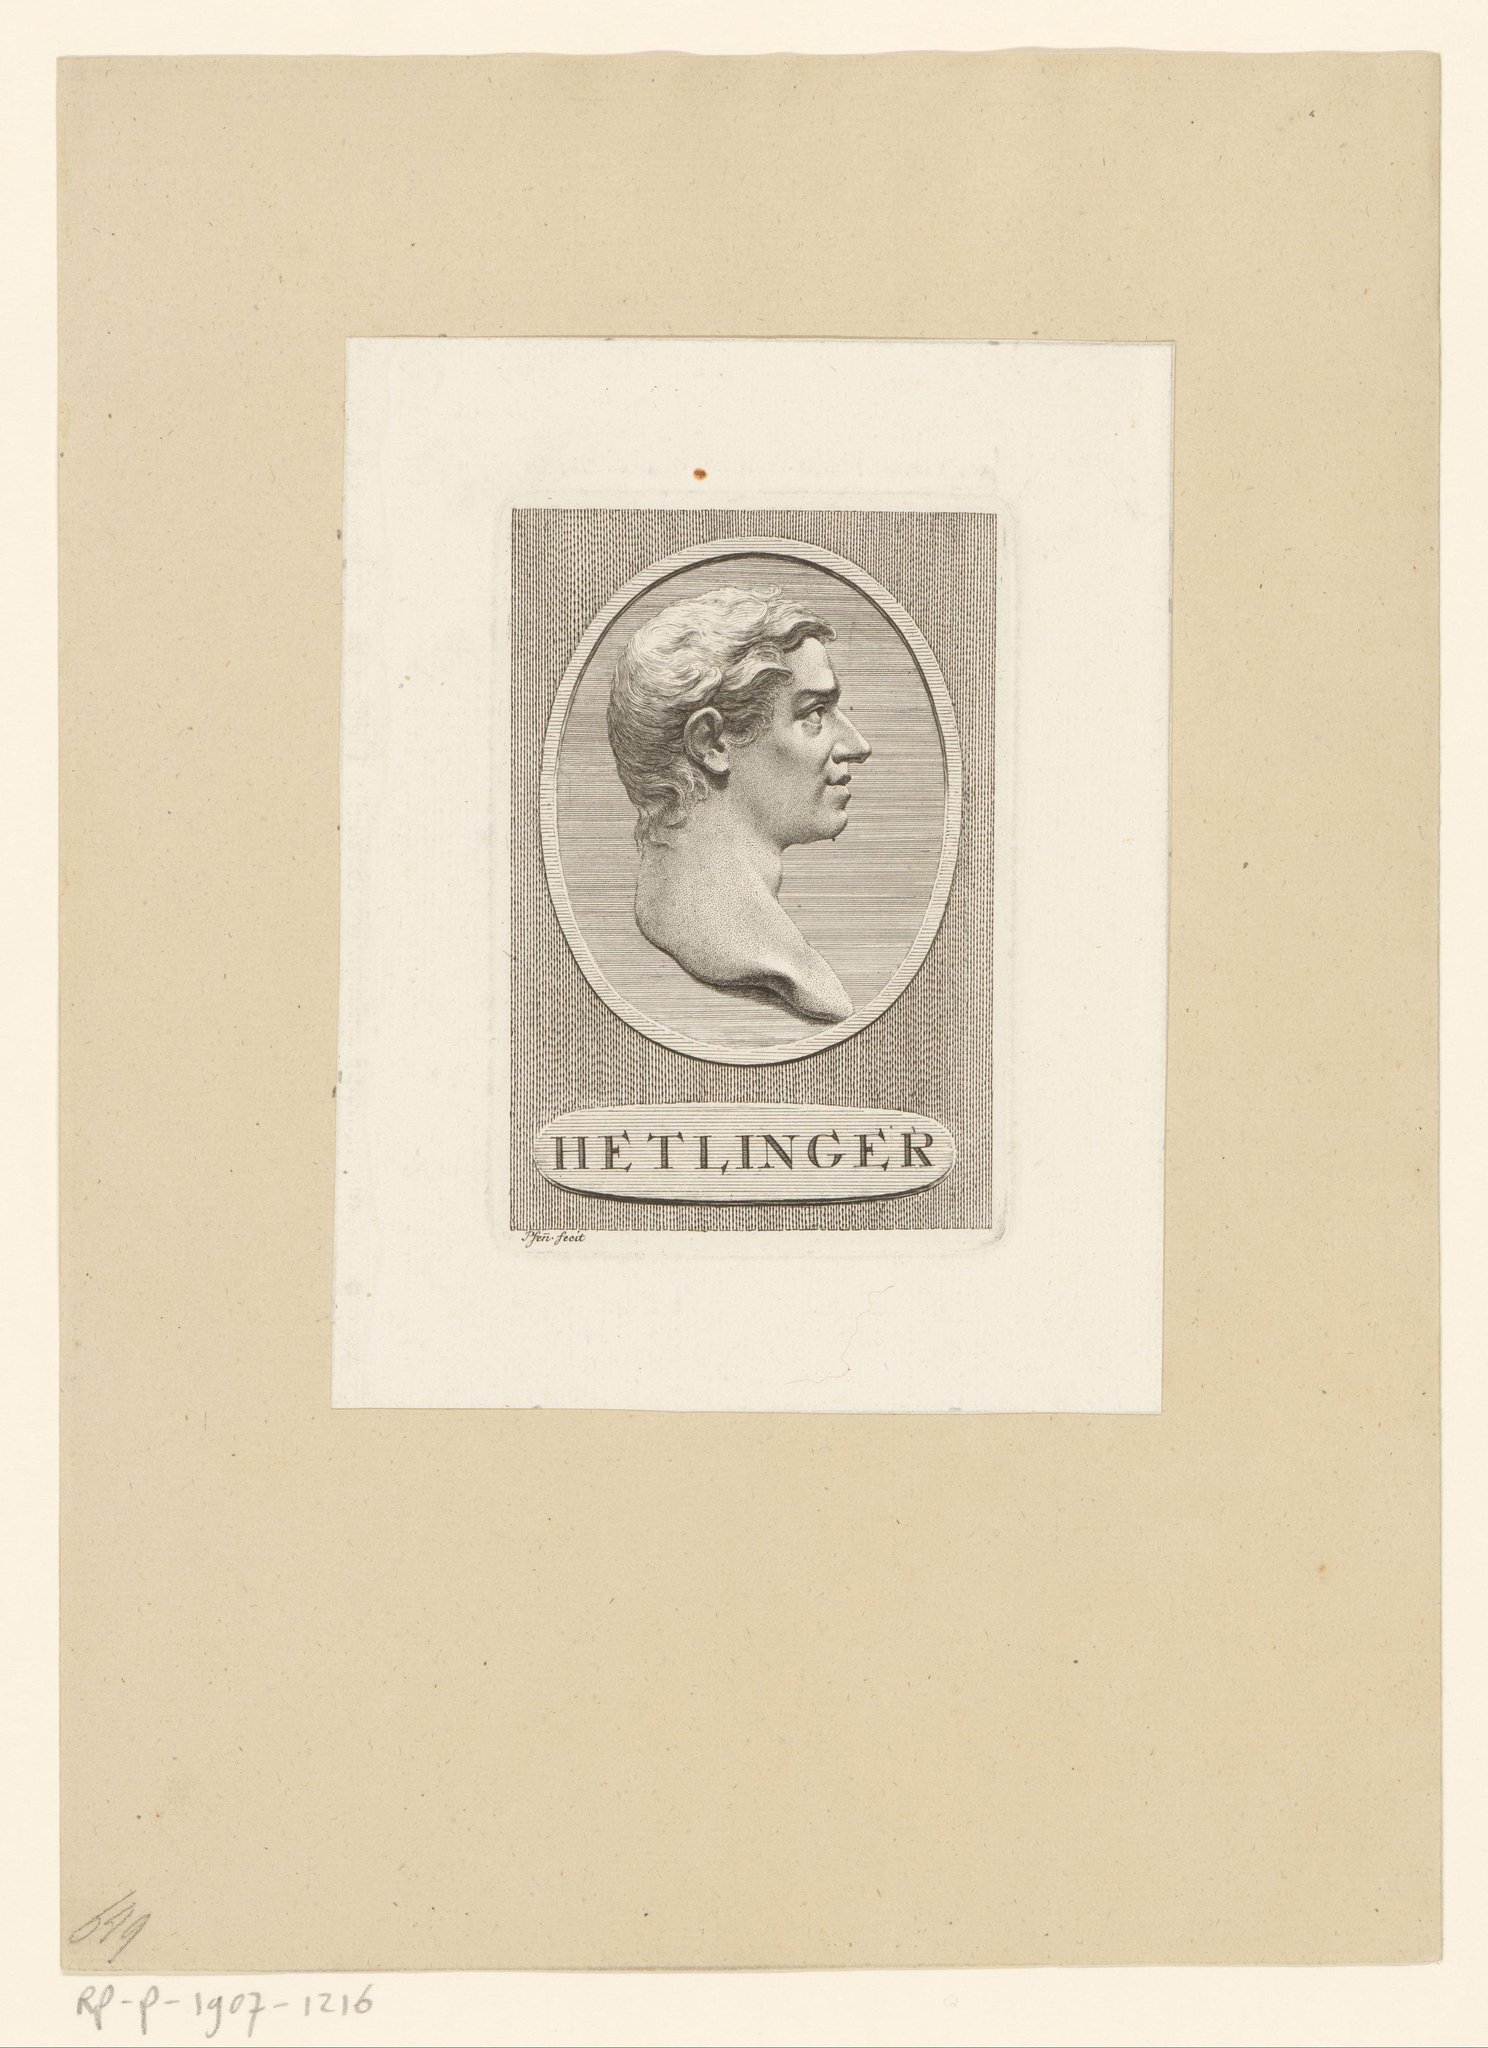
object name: print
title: Portret van Johann Jakob Hettlinger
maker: heinrich pfenninger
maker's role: print maker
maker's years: 1749-1815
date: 1759-1815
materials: paper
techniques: etching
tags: engineer, physicist, historical persons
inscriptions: collector's mark: Lugt 2228